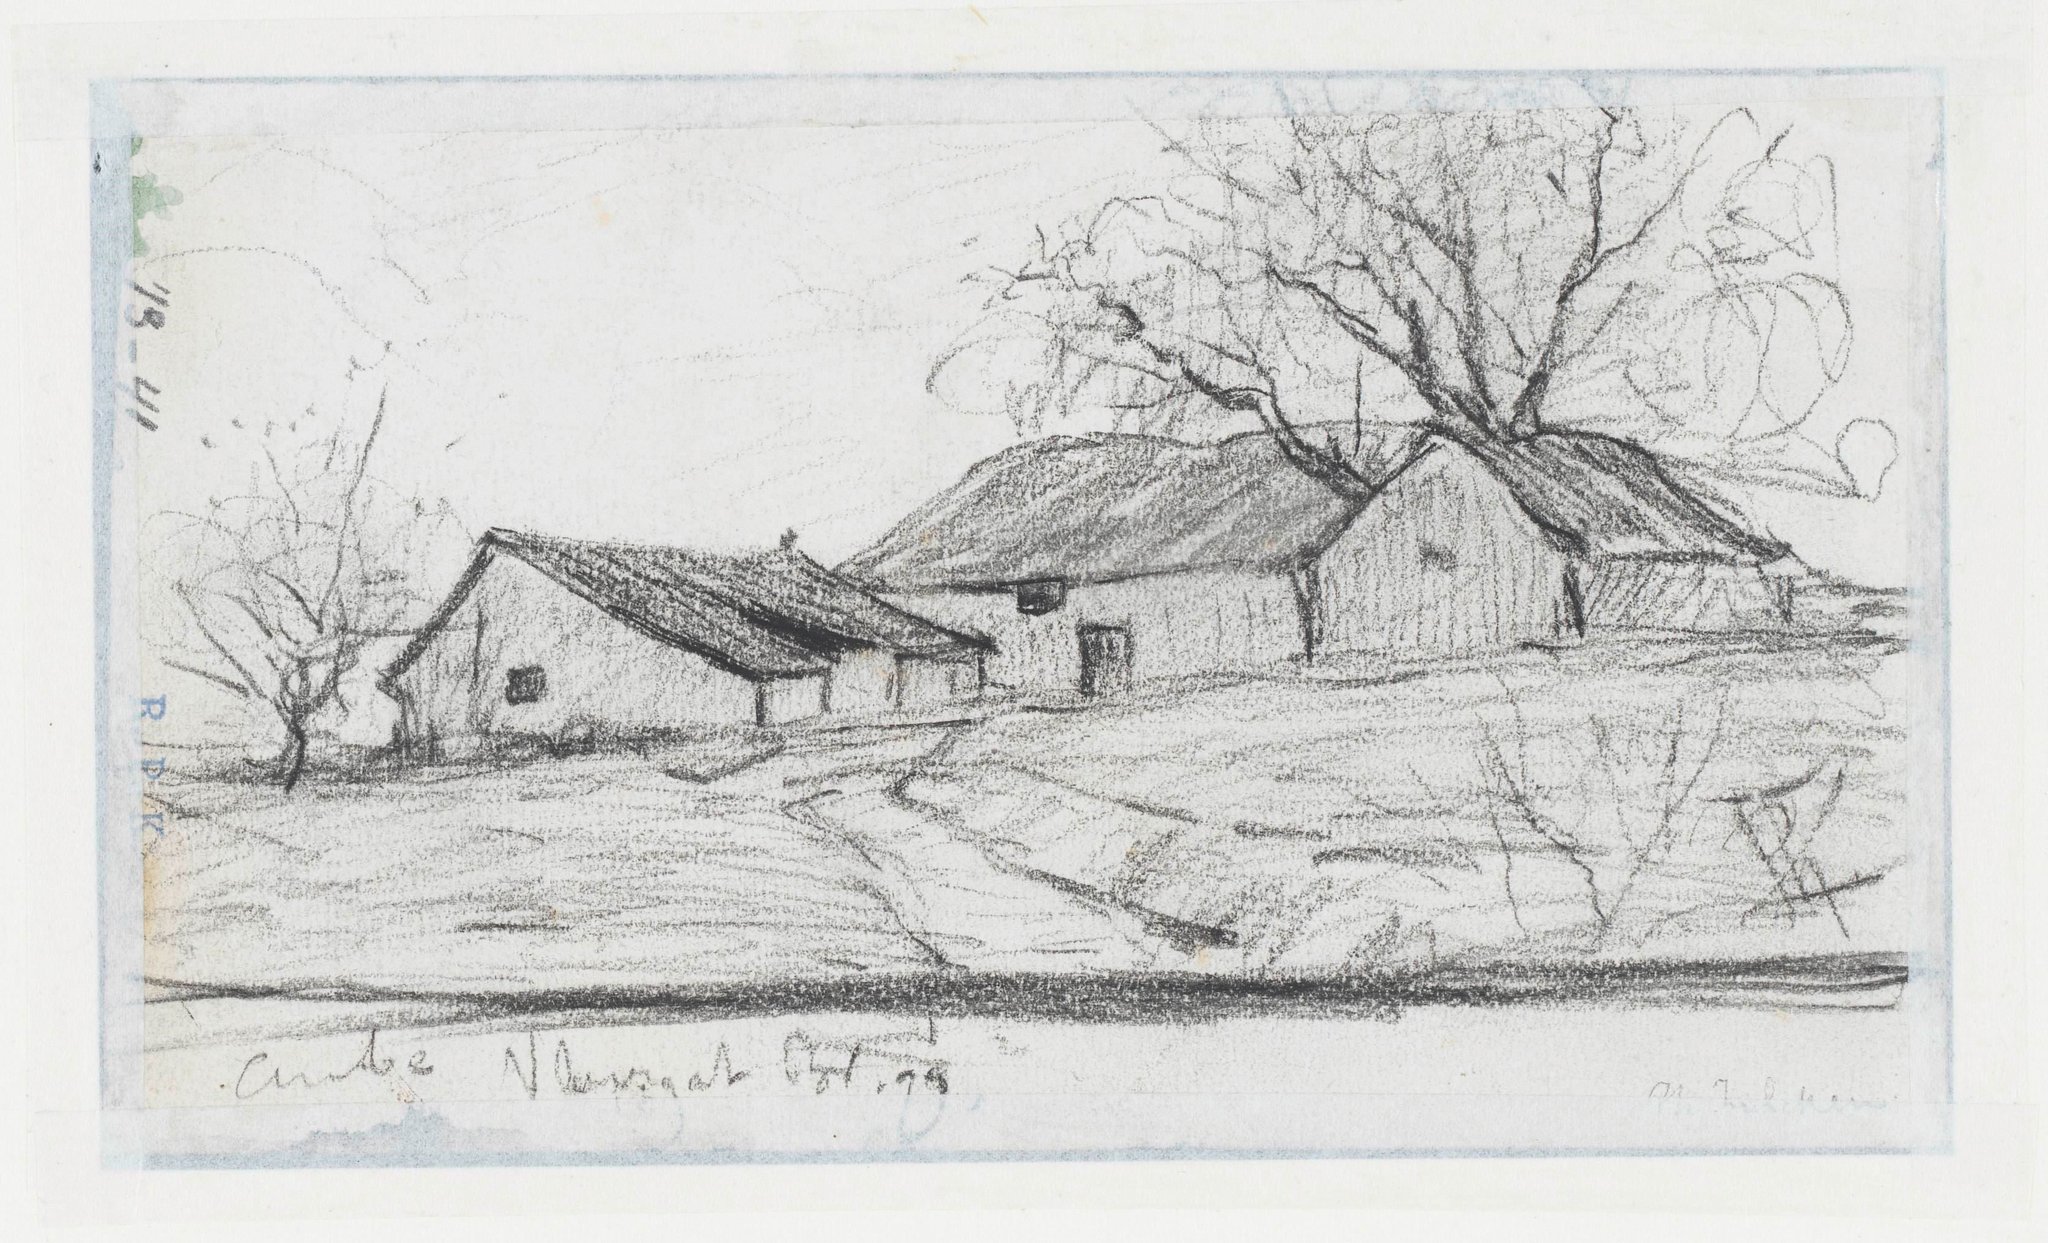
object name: drawing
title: Landschap met een boerderij en schuren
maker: philip zilcken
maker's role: draughtsman, painter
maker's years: 1857-1930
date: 1879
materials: chalk, paper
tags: barn, farm or solitary house in landscape, farm (building)